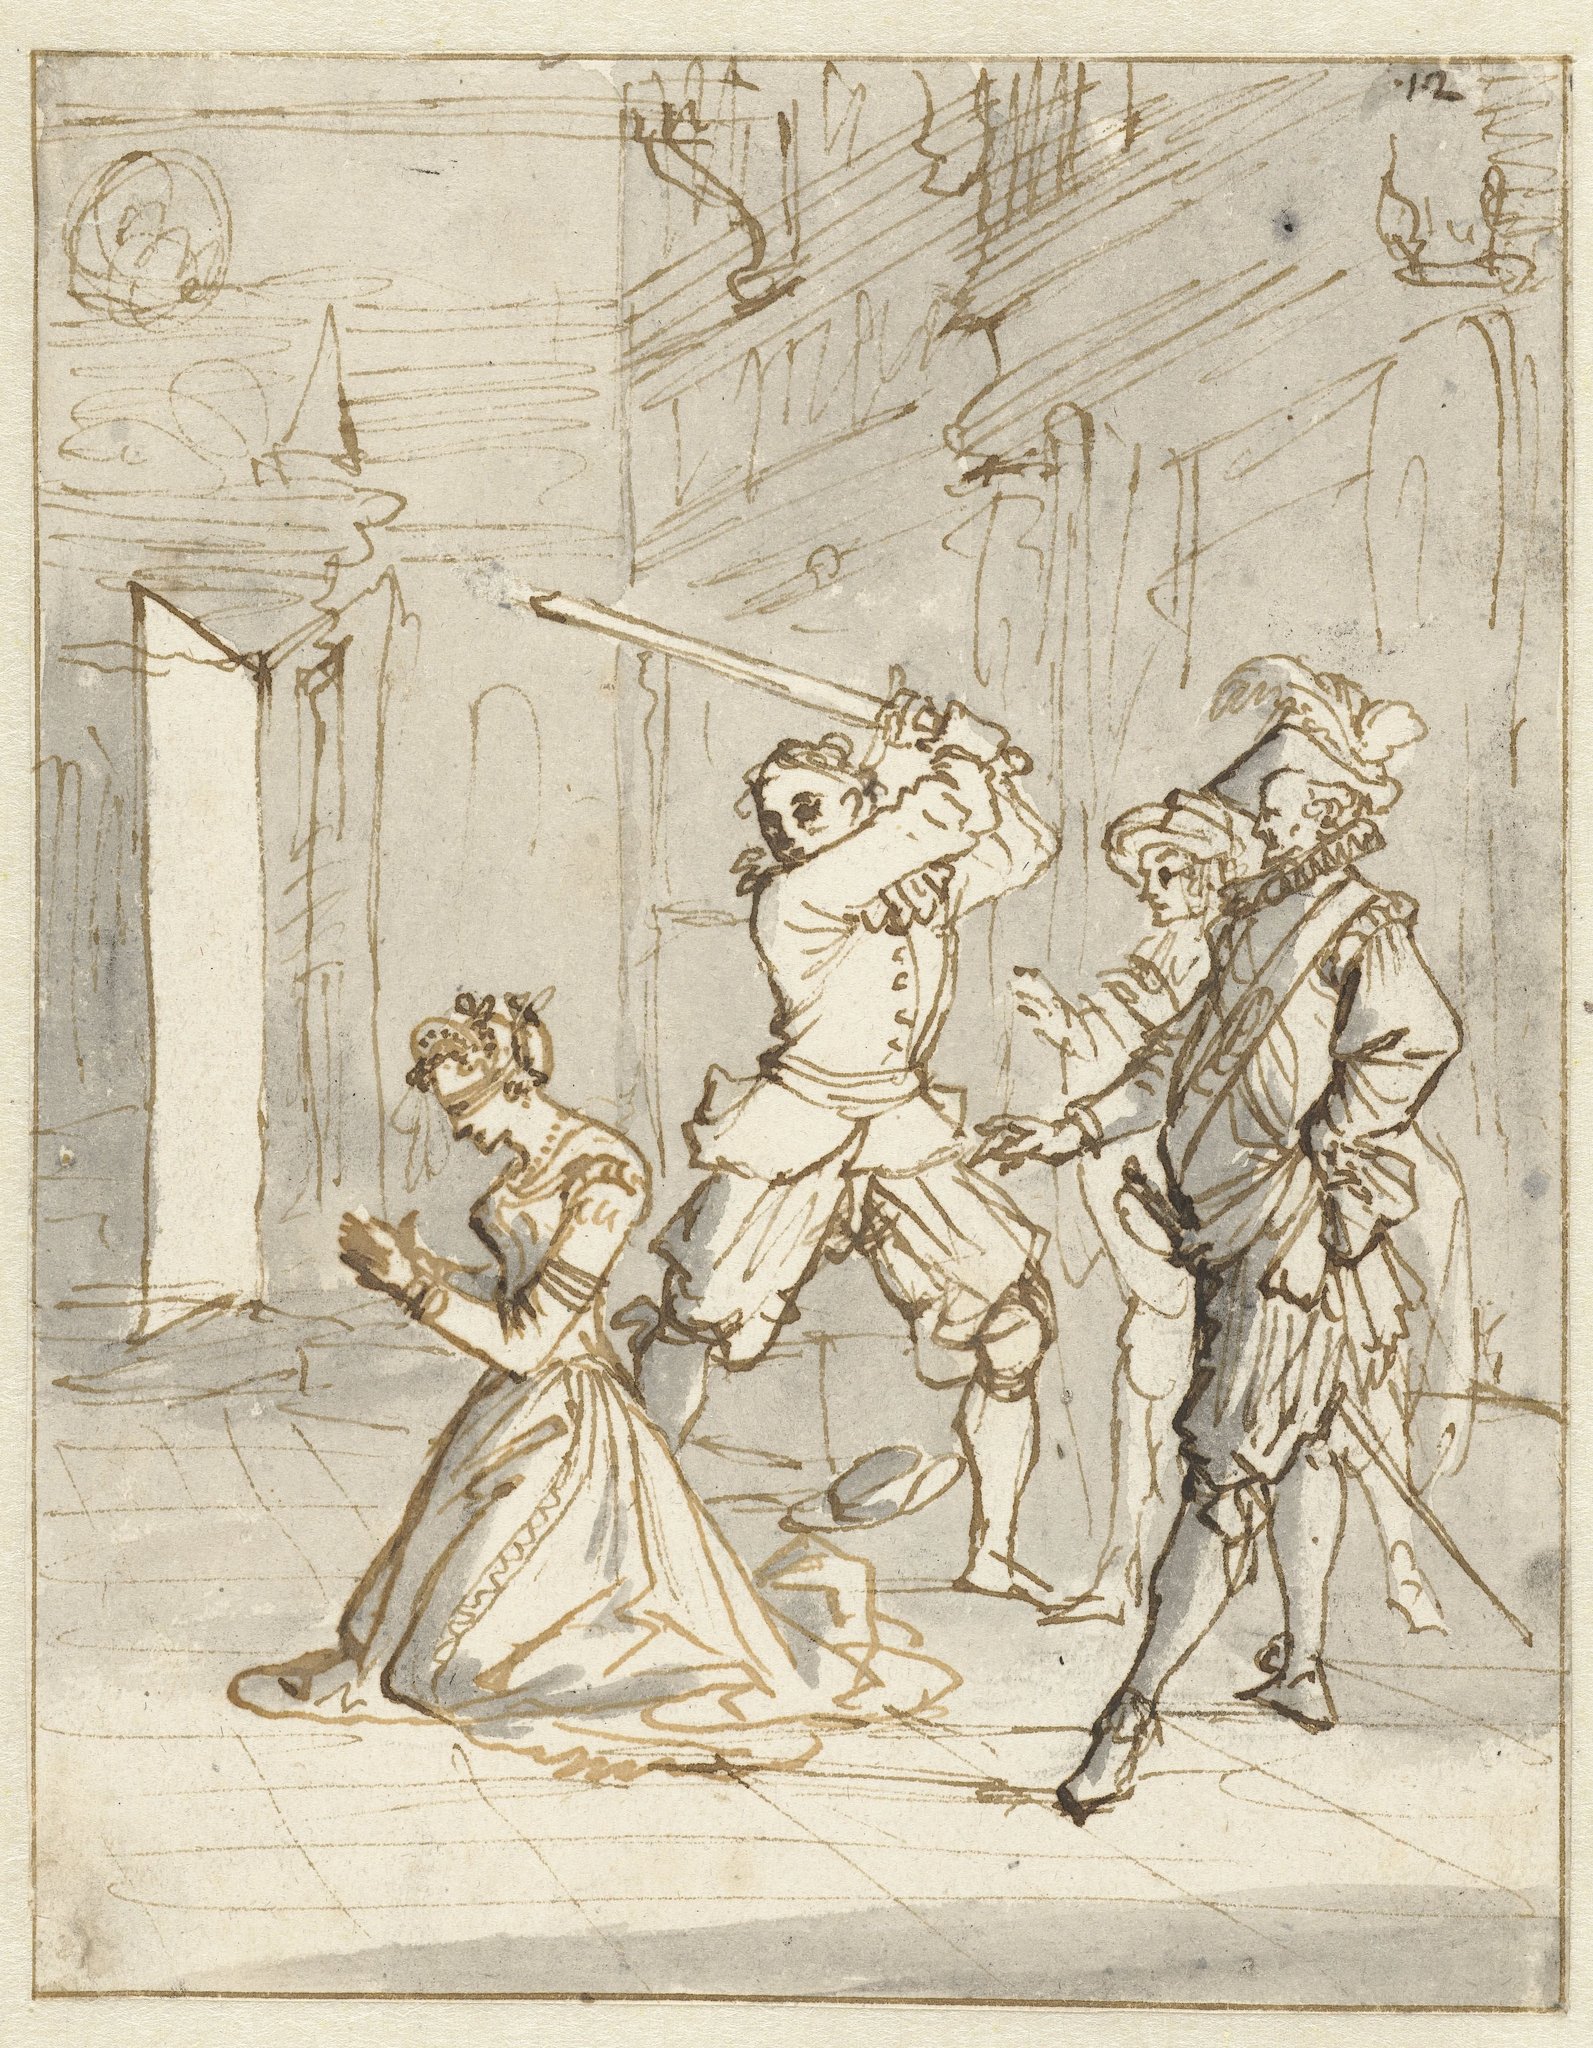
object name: design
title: Joachim Carpitzo laat zijn vrouw onthoofden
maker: jan luyken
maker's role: draughtsman, print maker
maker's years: 1649-1712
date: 1697-1699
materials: ink, paper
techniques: brush, pen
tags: historical persons, death penalty, execution, adultery revenged, violent death by beheading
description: Joachim Carpitzo laat zijn vrouw wegens overspel onthoofden. Ontwerp voor een prent.